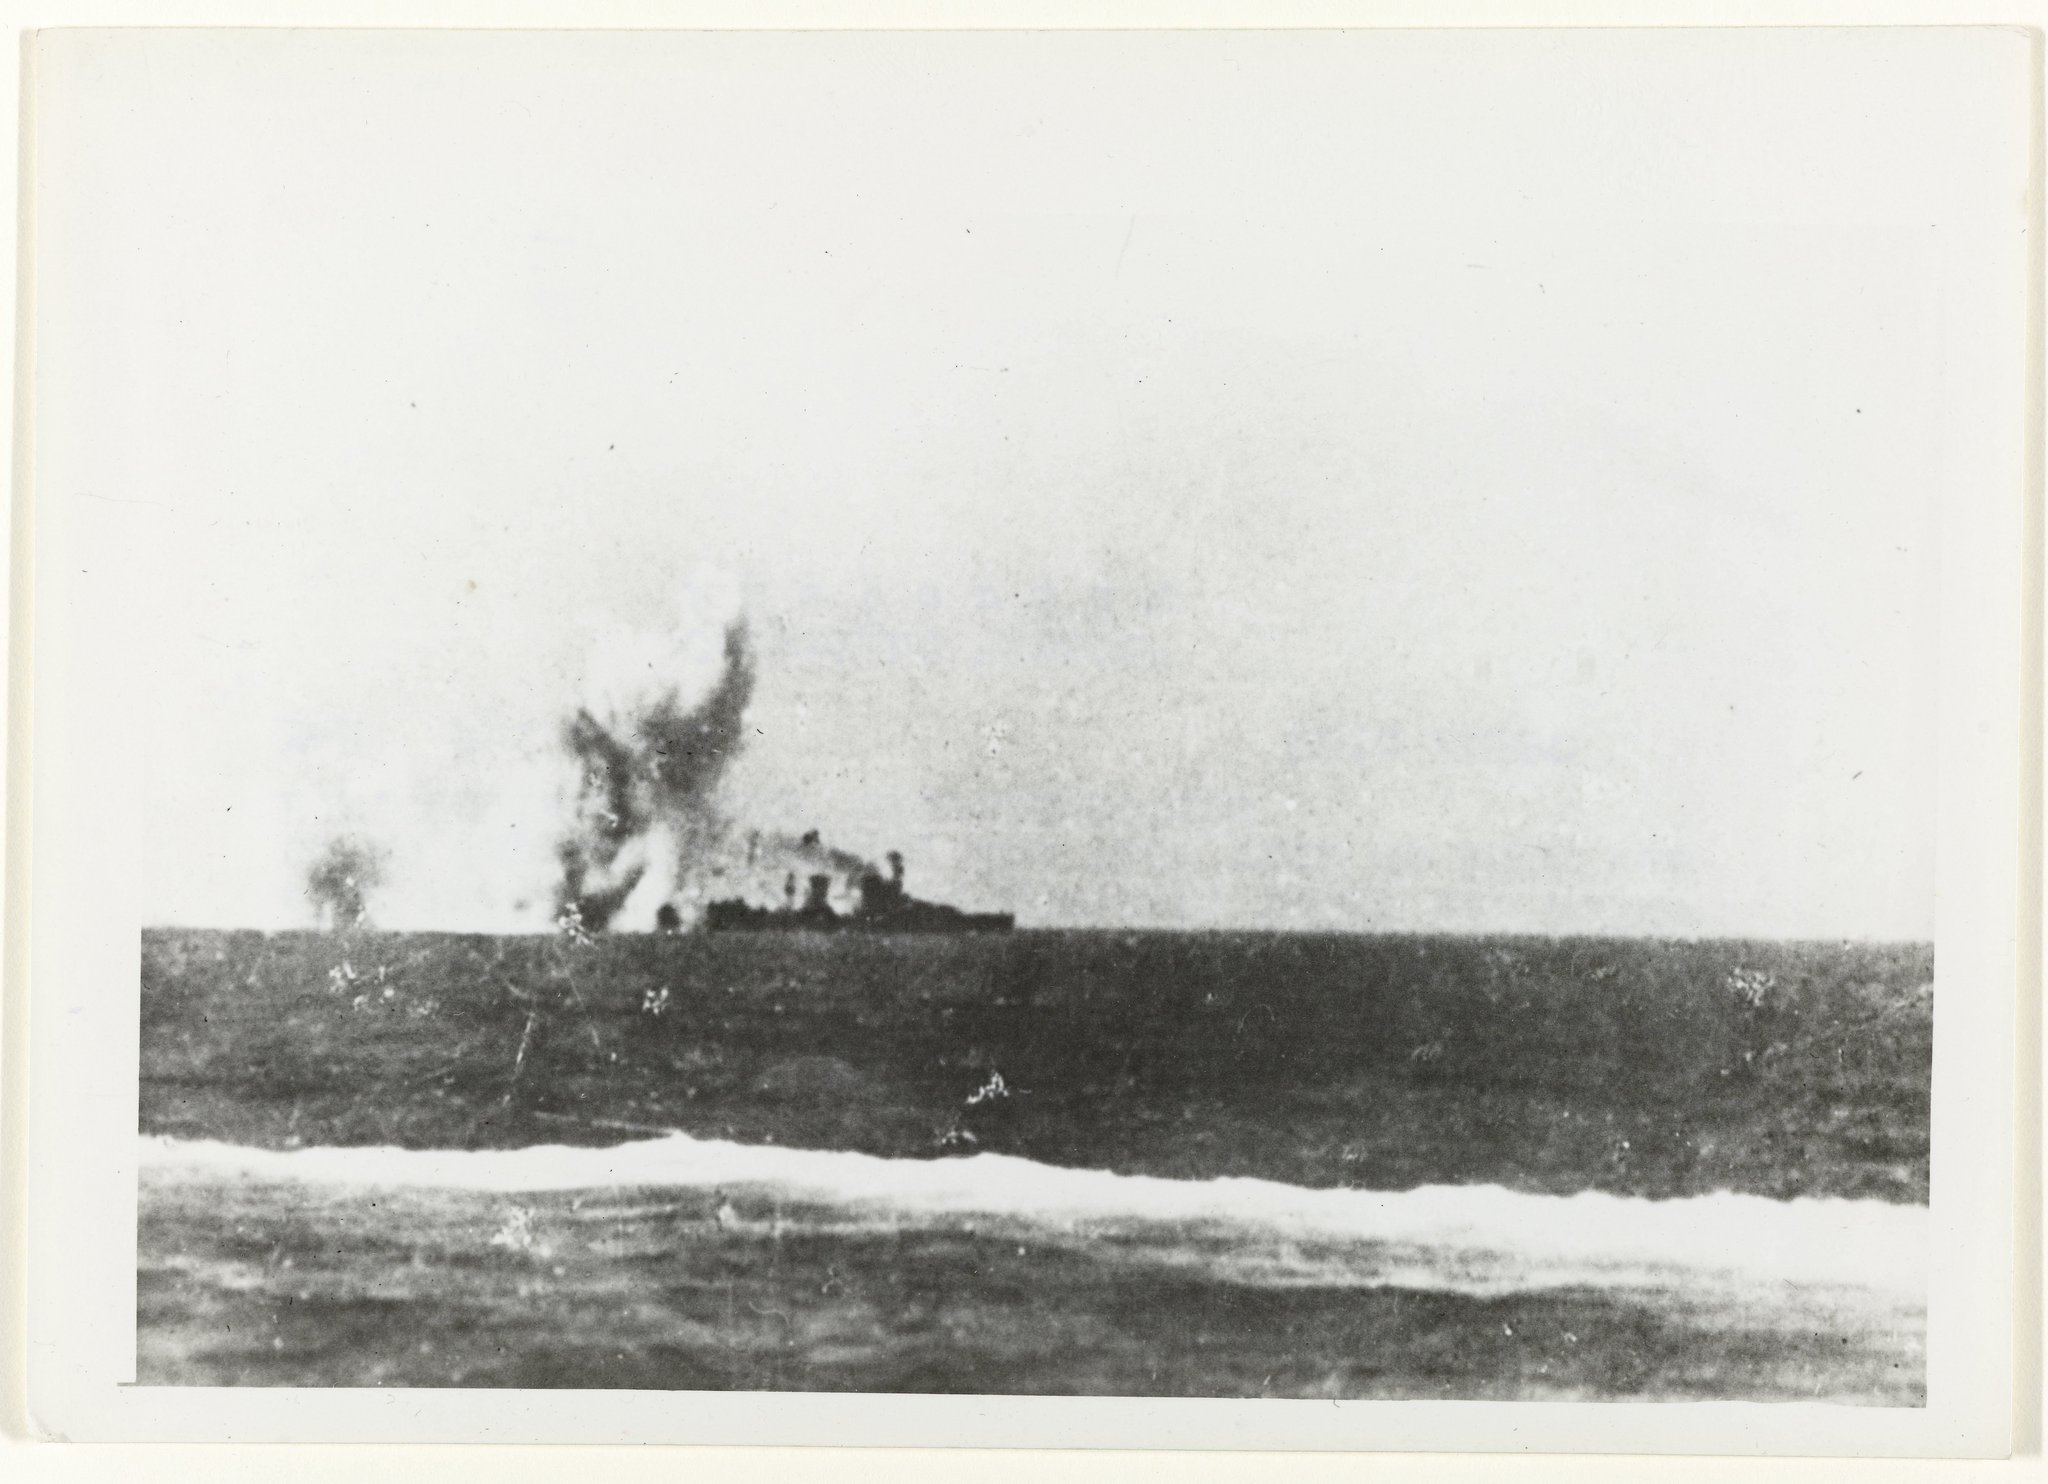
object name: photograph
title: Slag in de Javazee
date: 1942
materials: photographic support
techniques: photography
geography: indonesia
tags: indonesia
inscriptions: inscription, stamp: ‘COPYRIGHT / 'ANEFO' / ALGEMEEN NEDERLANDSCH FOTOBUREAU’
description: De slag in de Javazee: een salvo zware Japansche bommen spat uiteen vlak voor de boeg van kruiser Hr. Ms. Java.